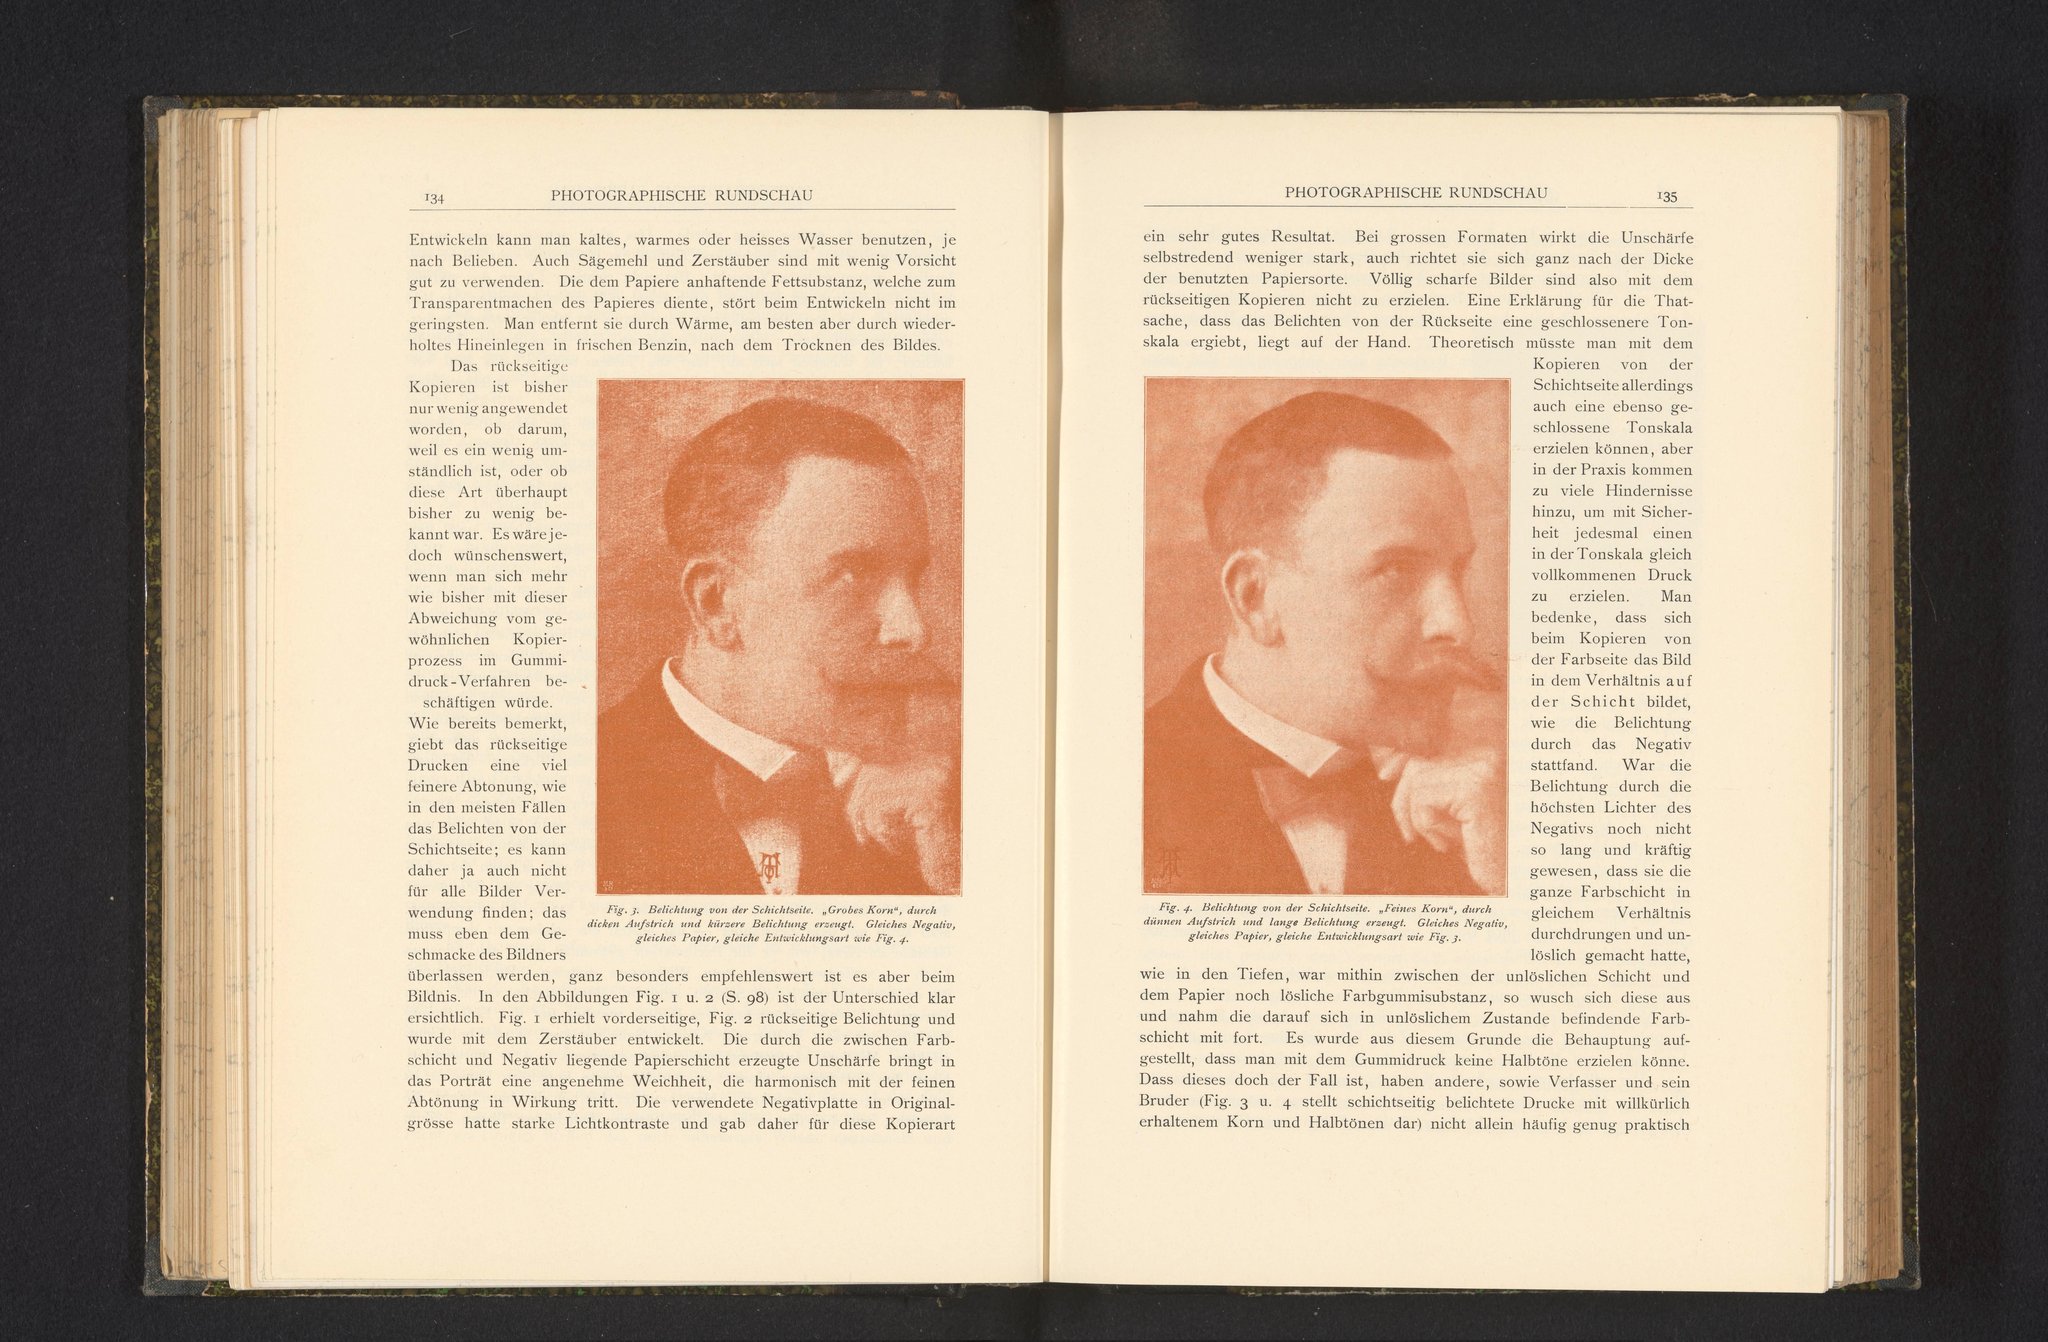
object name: page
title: Portret van een onbekende man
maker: Anonymous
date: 1893-1898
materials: paper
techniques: autotype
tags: adult man